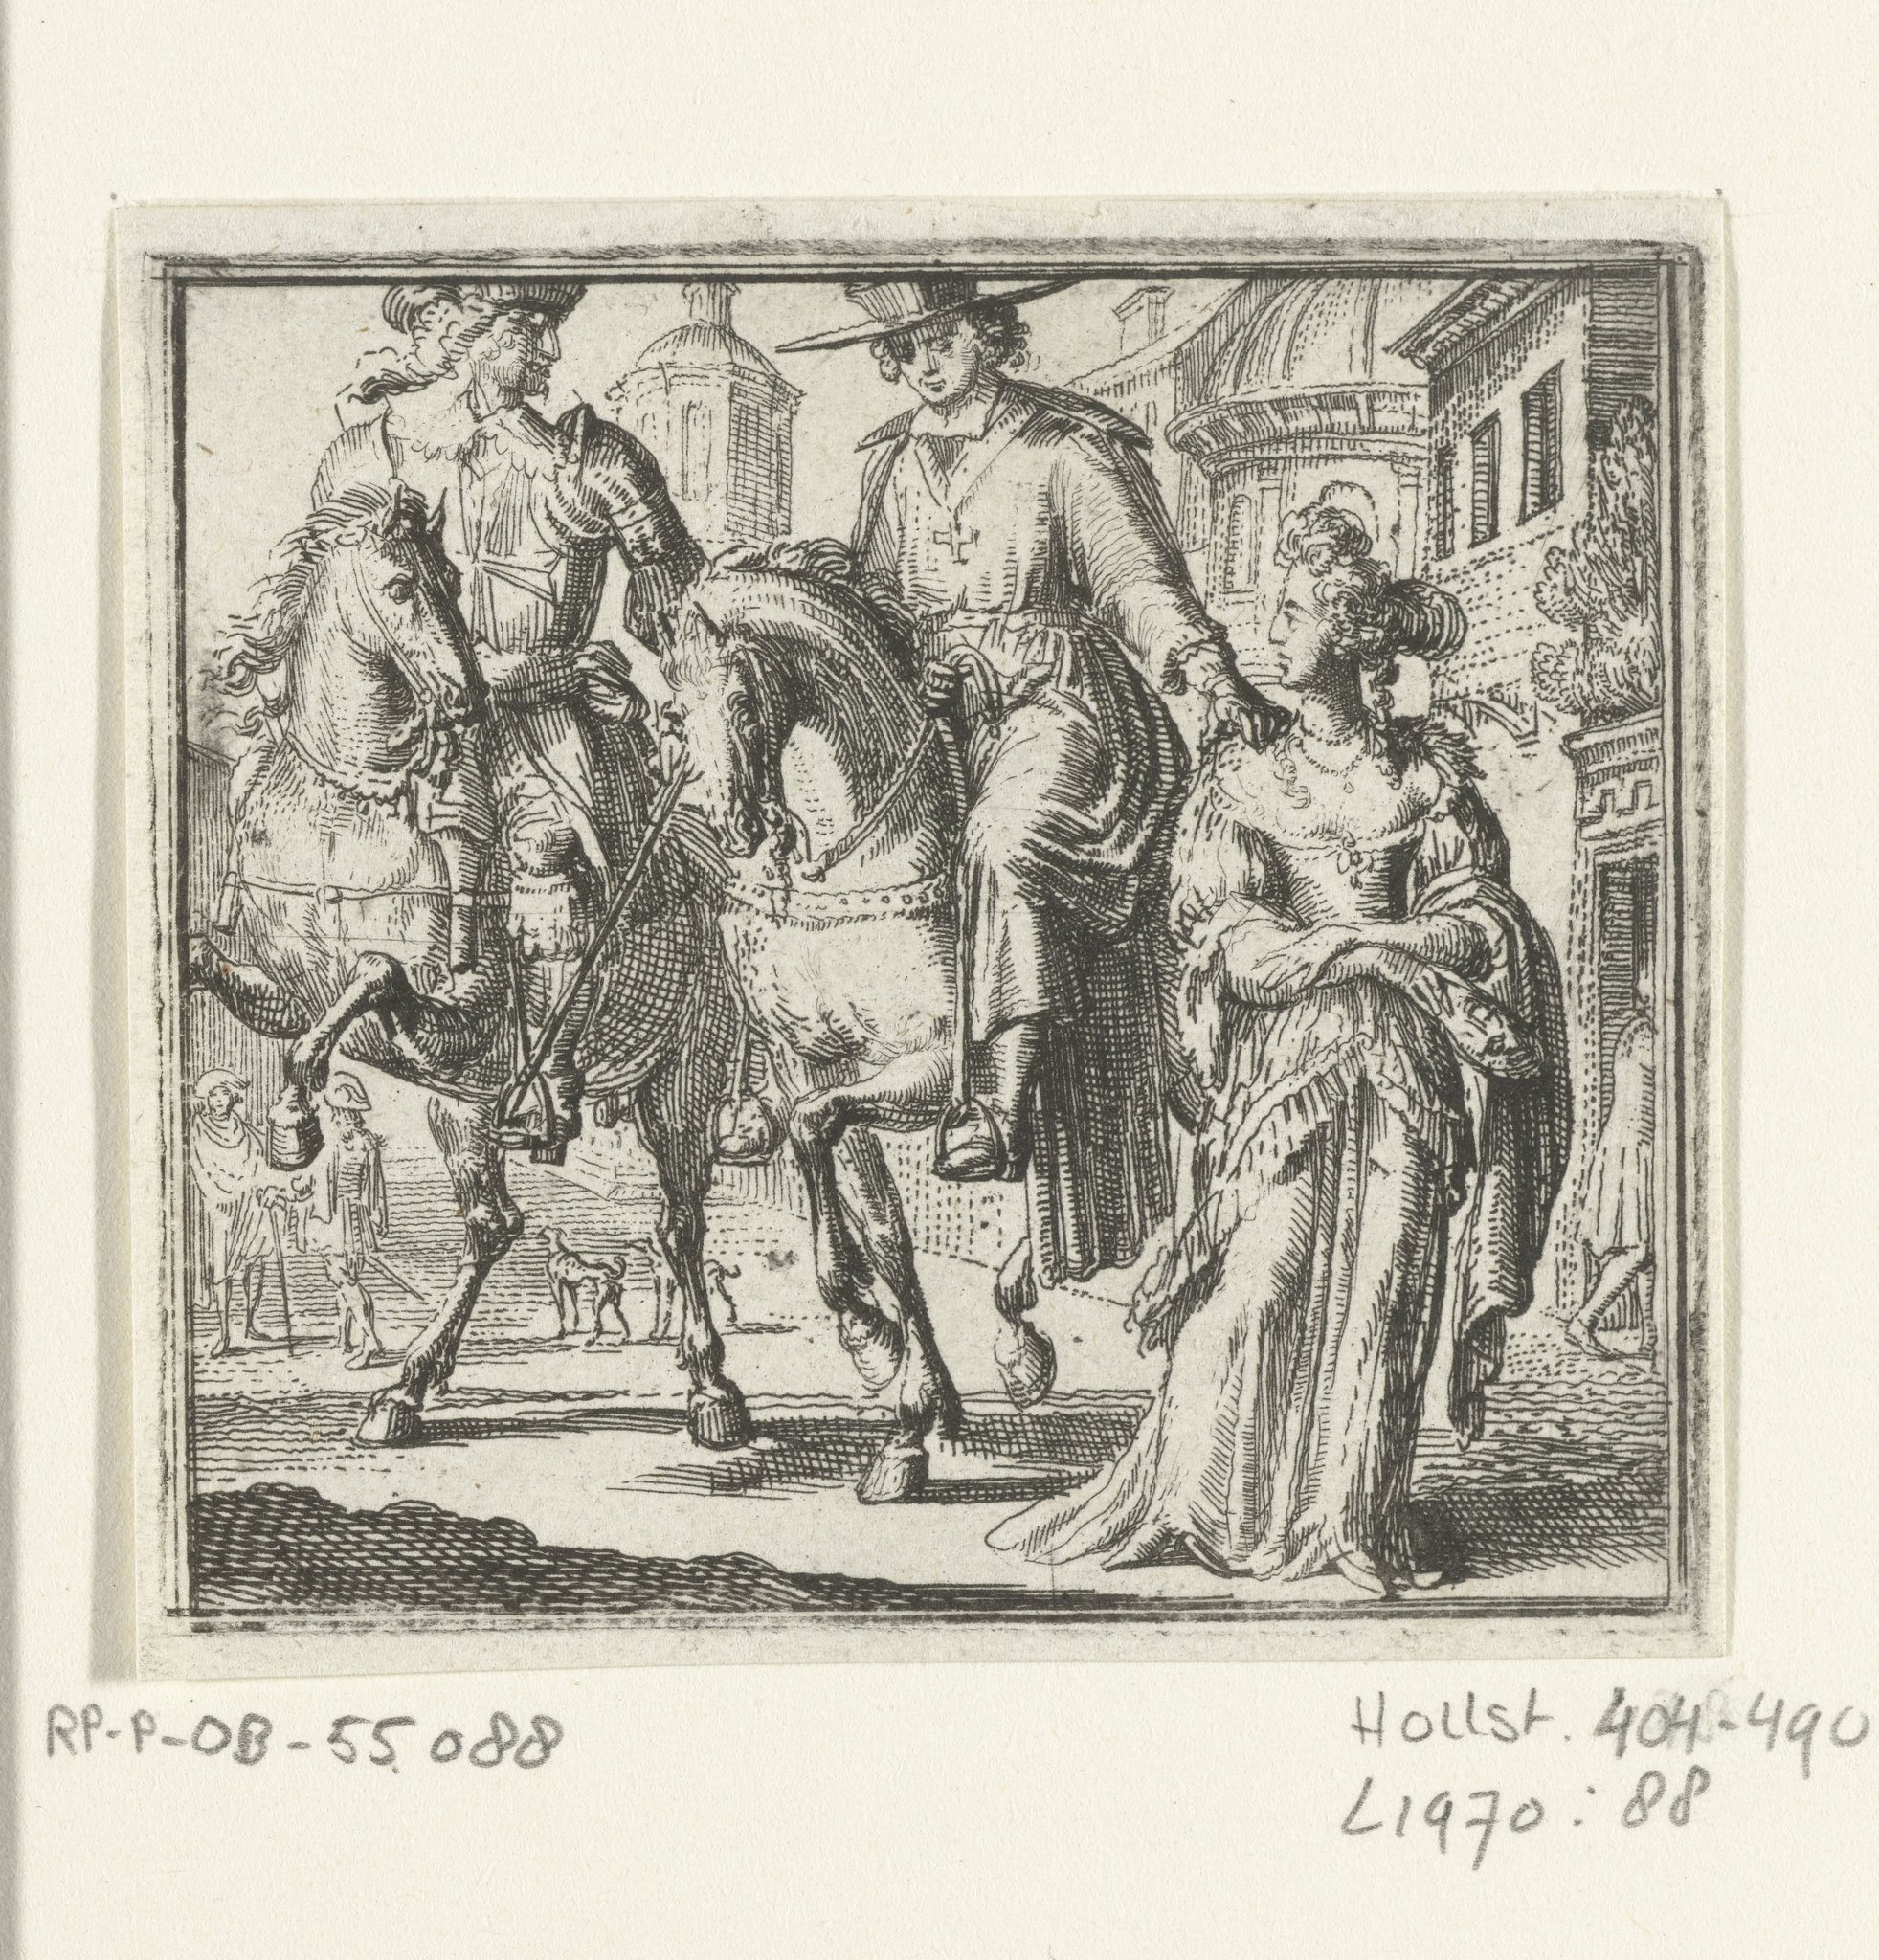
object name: print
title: Illustratie voor de Decamerone van Boccaccio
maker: romeyn de hooghe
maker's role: draughtsman, goldsmith, painter, print maker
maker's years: 1645-1708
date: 1697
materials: paper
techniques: etching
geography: netherlands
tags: (scenes from) specific works of literature: boccaccio, decamerone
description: Illustratie voor: Contes et nouvelles de Bocace Florentin. Traduction libre, 2 delen, Amsterdam, George Gallet, 1697. Latere edities met dezelfde illustraties uit 1699, 1702, 1732.